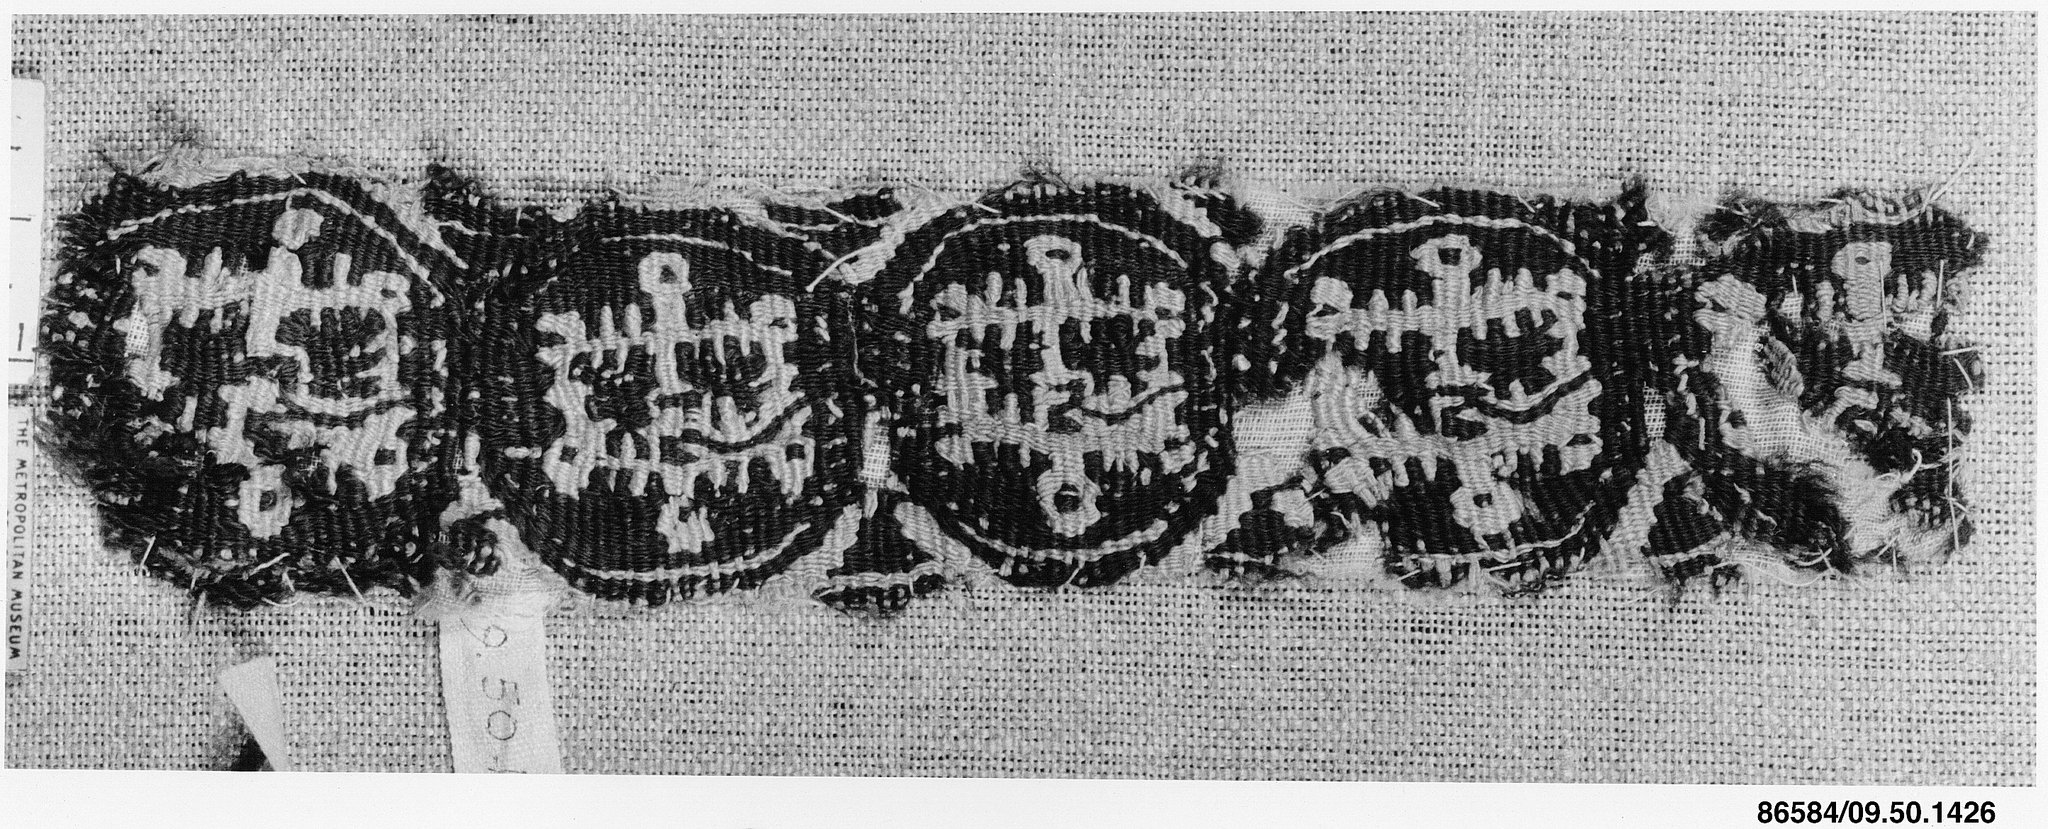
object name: band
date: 301-500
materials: linen, wool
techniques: weave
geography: egypt